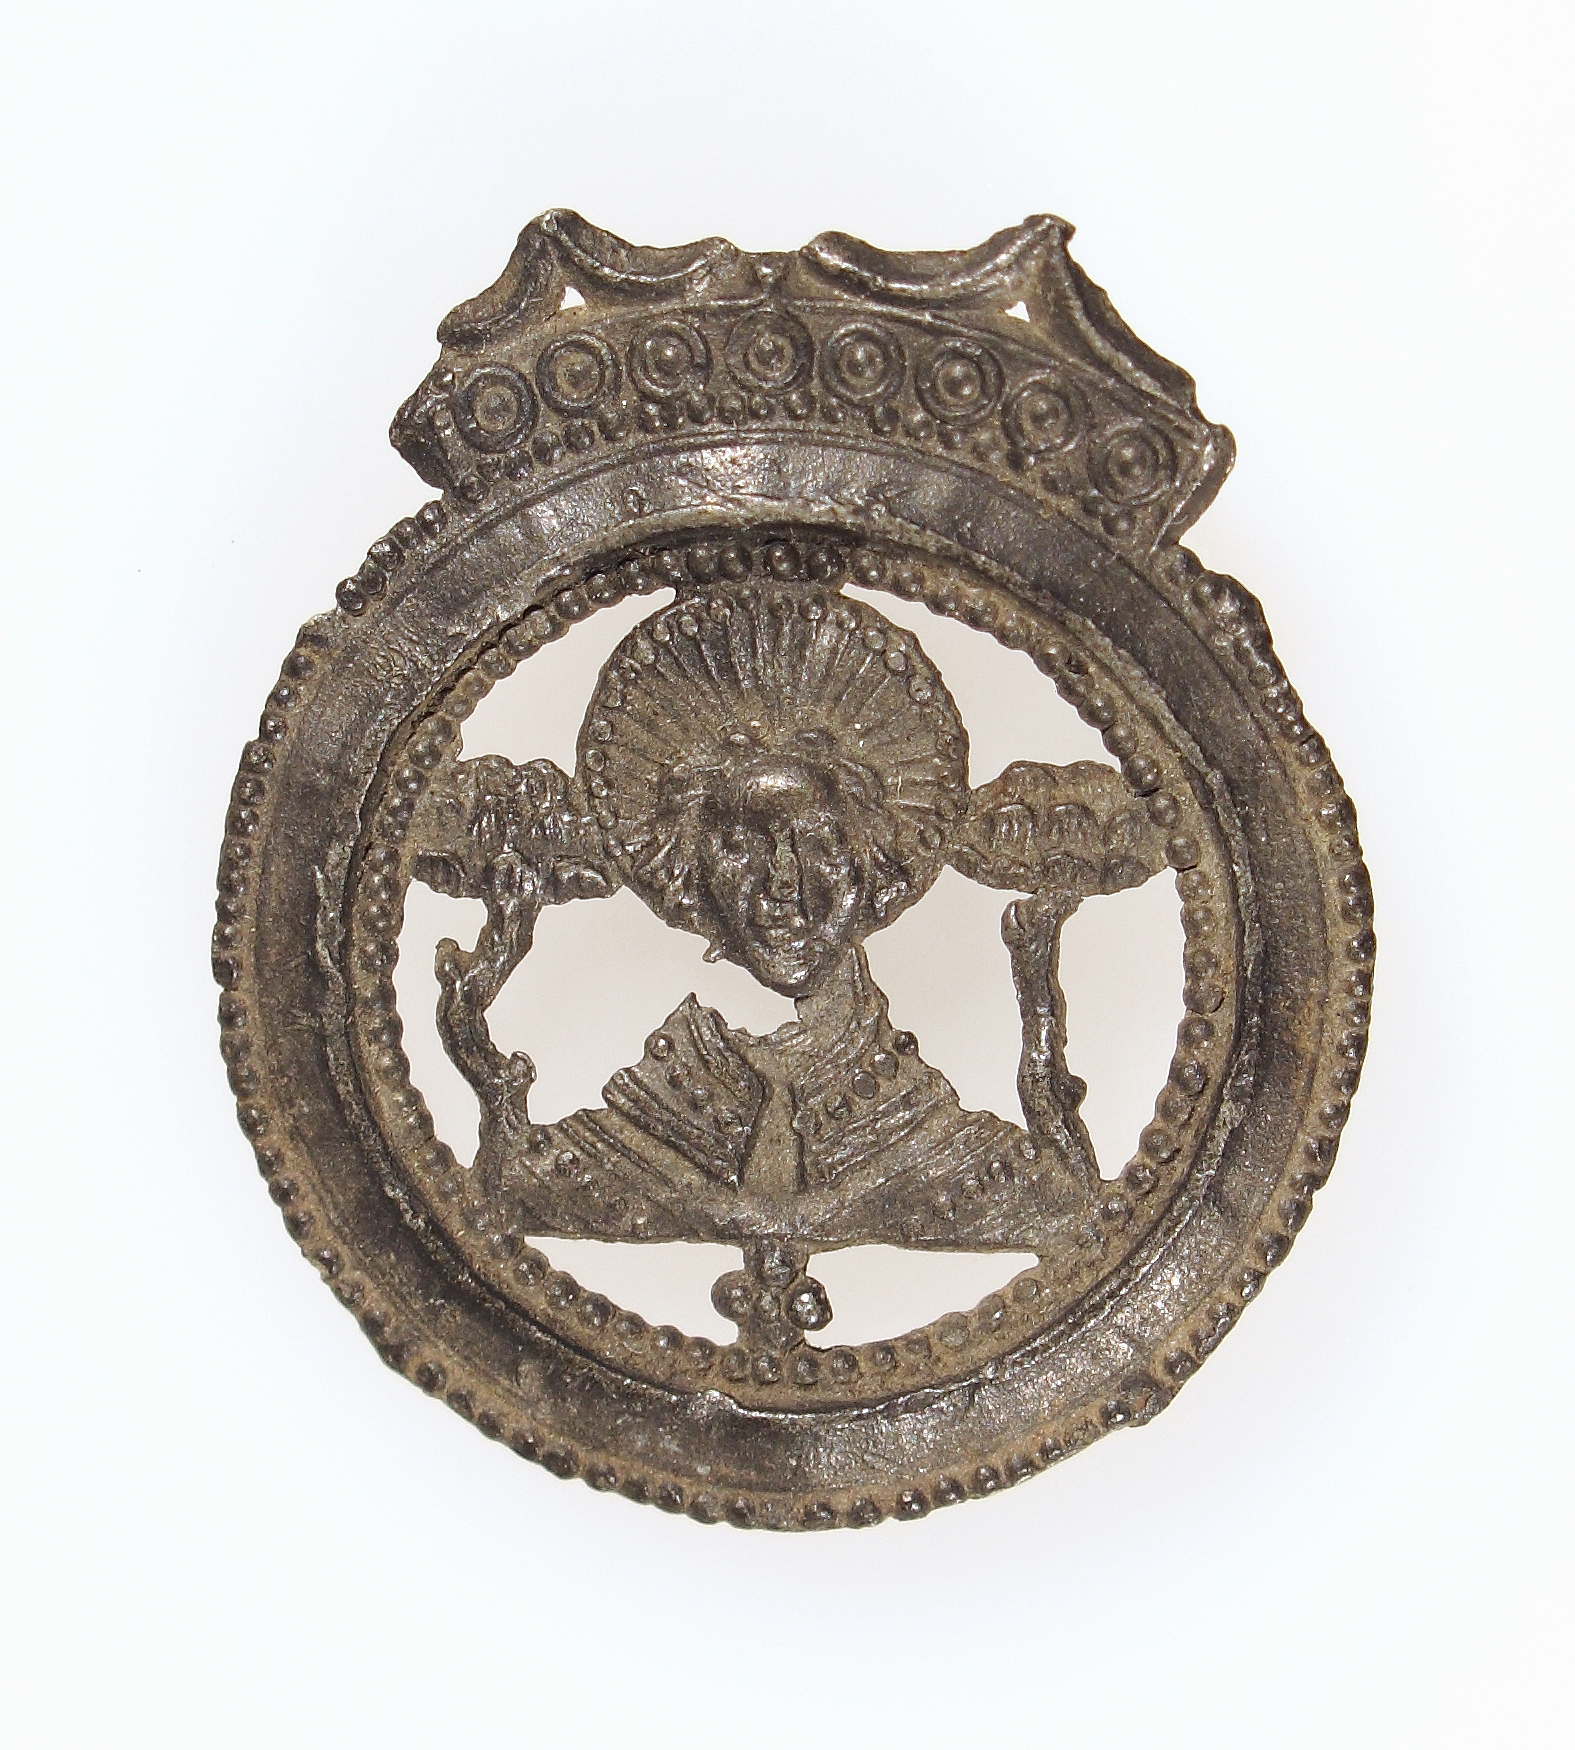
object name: pilgrim's badge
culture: french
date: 1301-1600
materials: lead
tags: saints